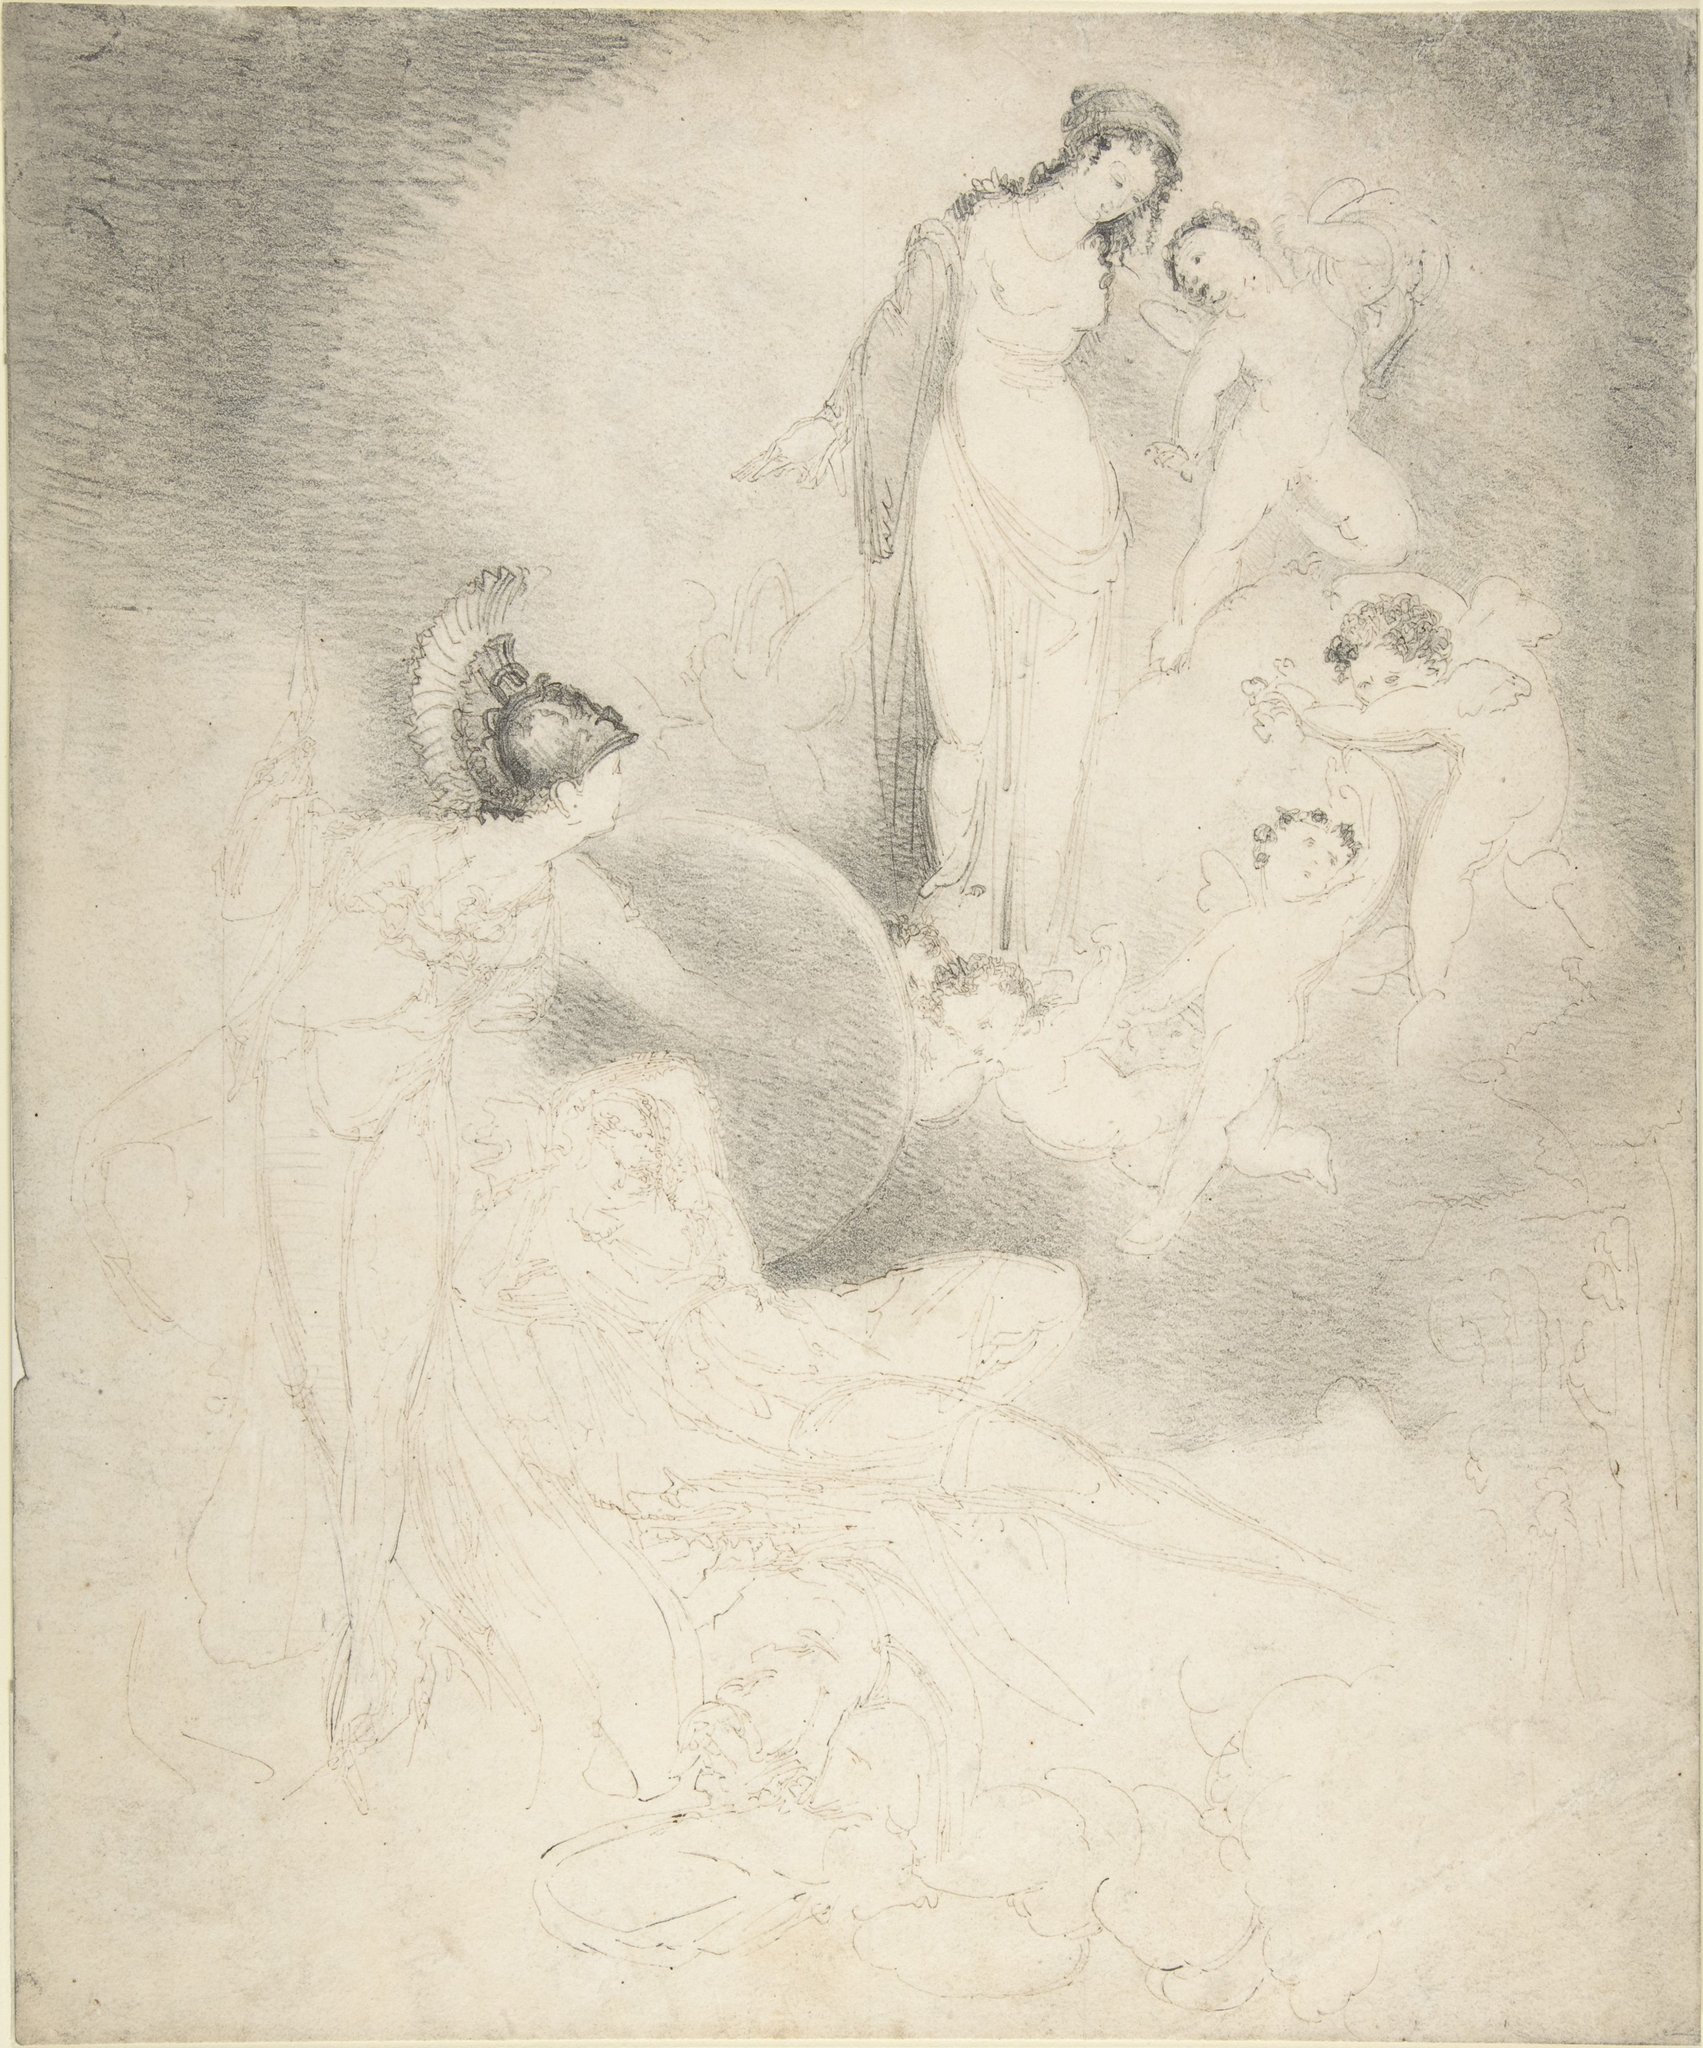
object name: drawing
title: Scene with Classical Figures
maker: william pitts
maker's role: artist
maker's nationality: british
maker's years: 1790-1840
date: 1805-1840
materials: chalk, graphite, ink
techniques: pen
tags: women